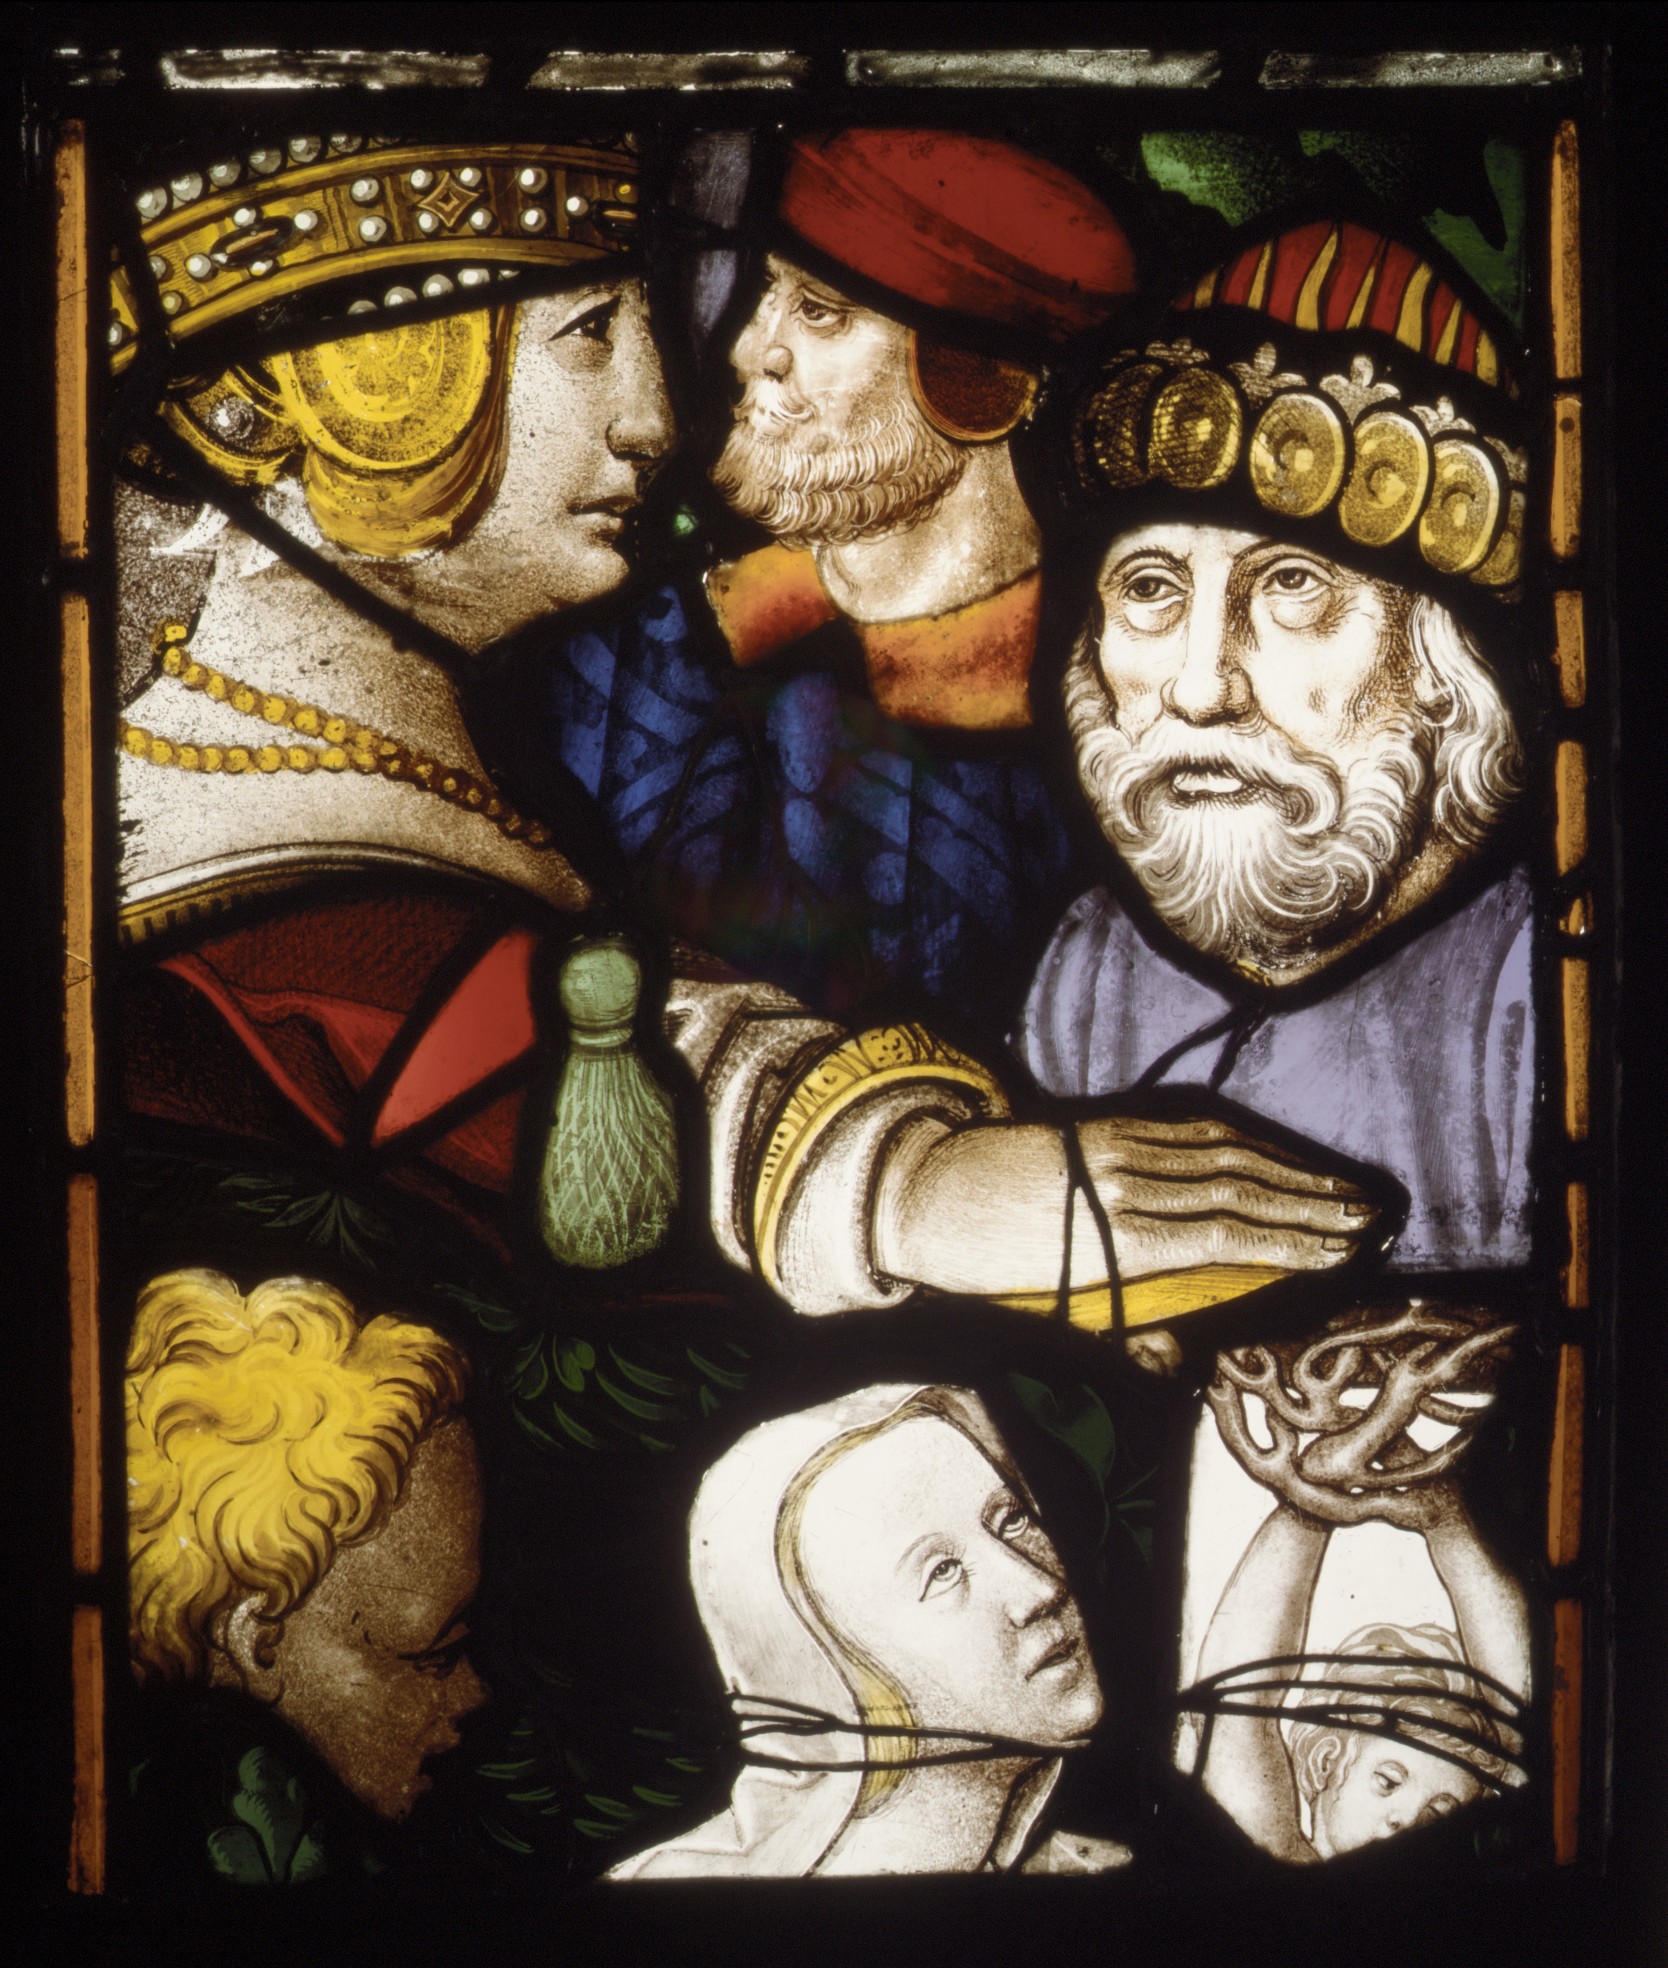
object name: panel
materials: glass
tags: men,women